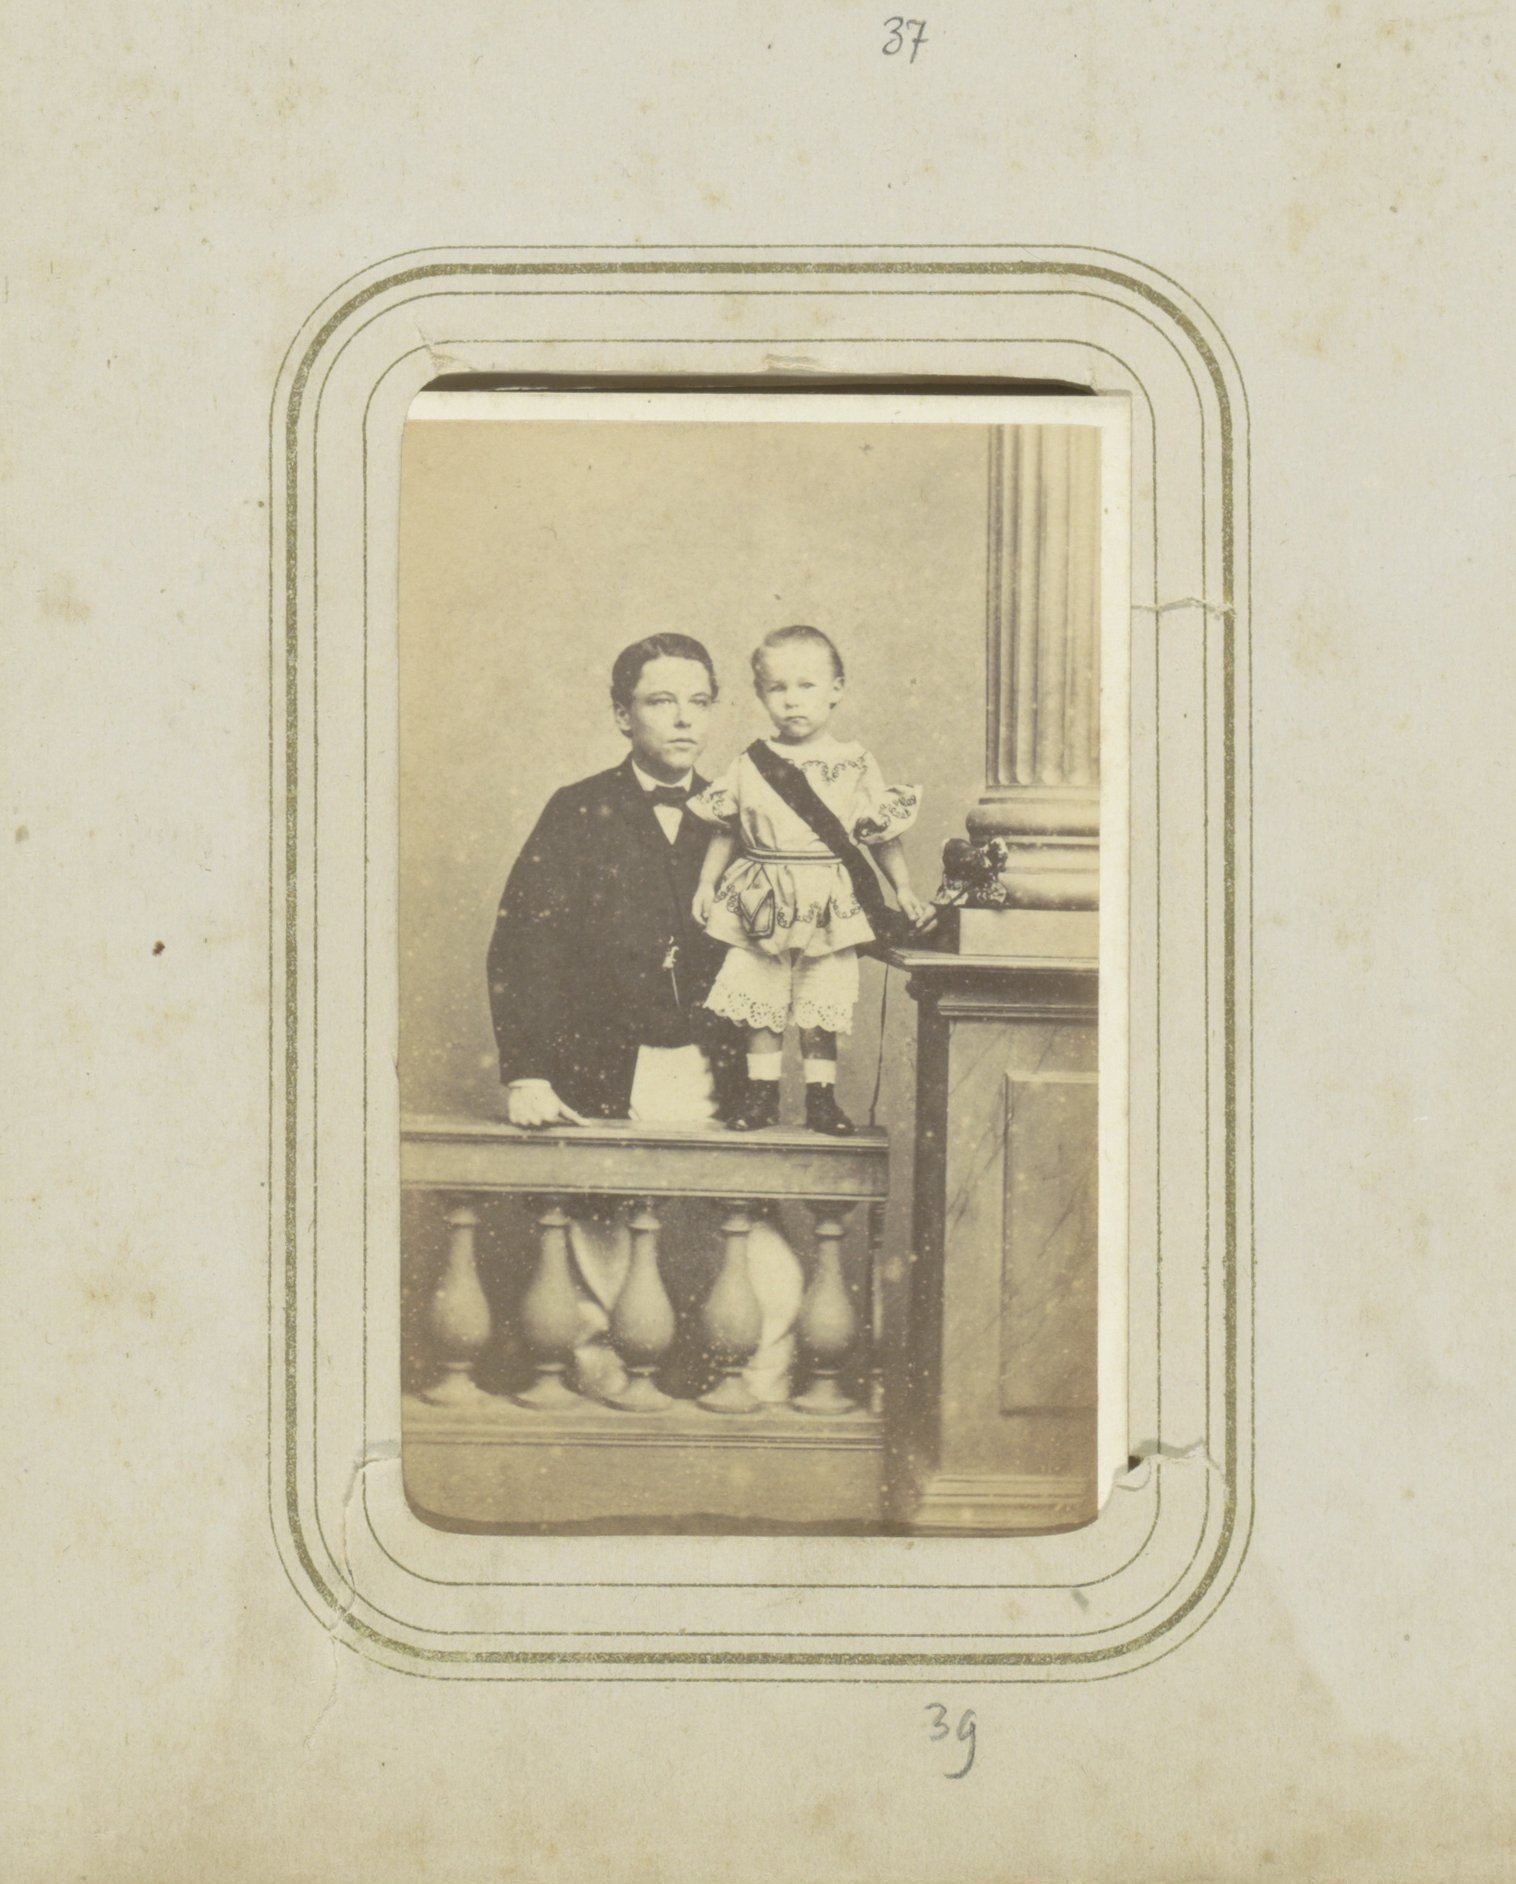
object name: carte de visite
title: Portret van een man met een klein kind met een sjerp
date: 1857-1880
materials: cardboard, photographic support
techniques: albumen print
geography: java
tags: studio requisites ~ photographer, trousers, breeches, historical persons, neck-gear ~ clothing, clothing for the upper part of the body, family, relationship, descent, tot, toddler ~ the ages of man, coat, cape, java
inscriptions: address: ‘Java’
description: Onderdeel van Familiealbum van H.W.F. Ligtenberg en L.M. Swart met 149 foto's en cartes-de-visite.